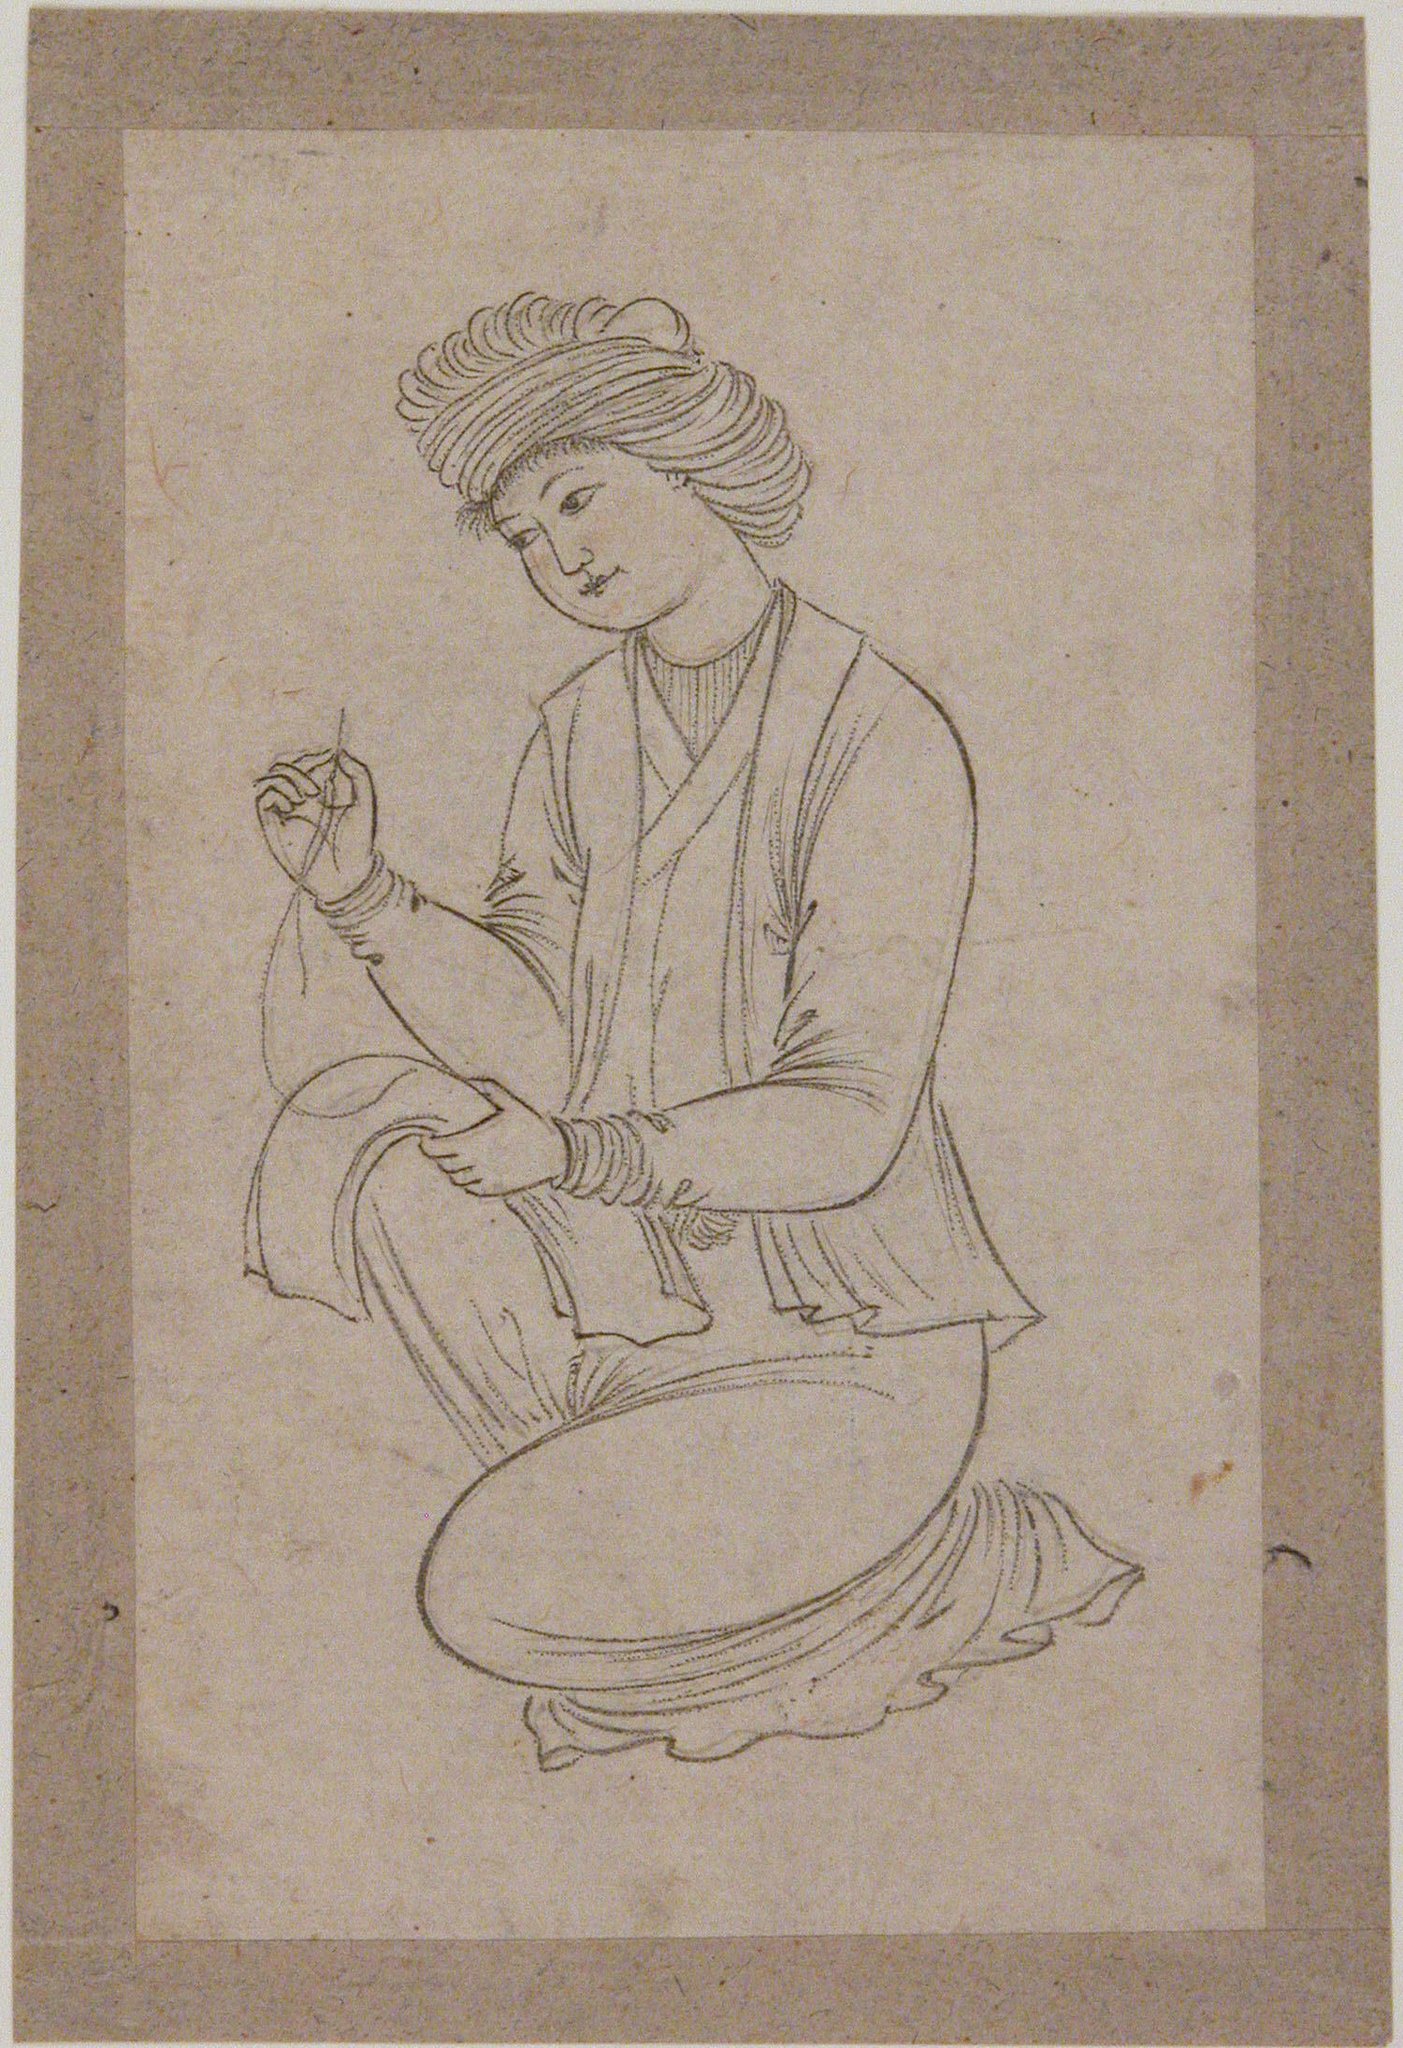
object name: illustrated single work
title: Young Man Sewing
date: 1601-1650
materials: ink, paper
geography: iran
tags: men,sewing